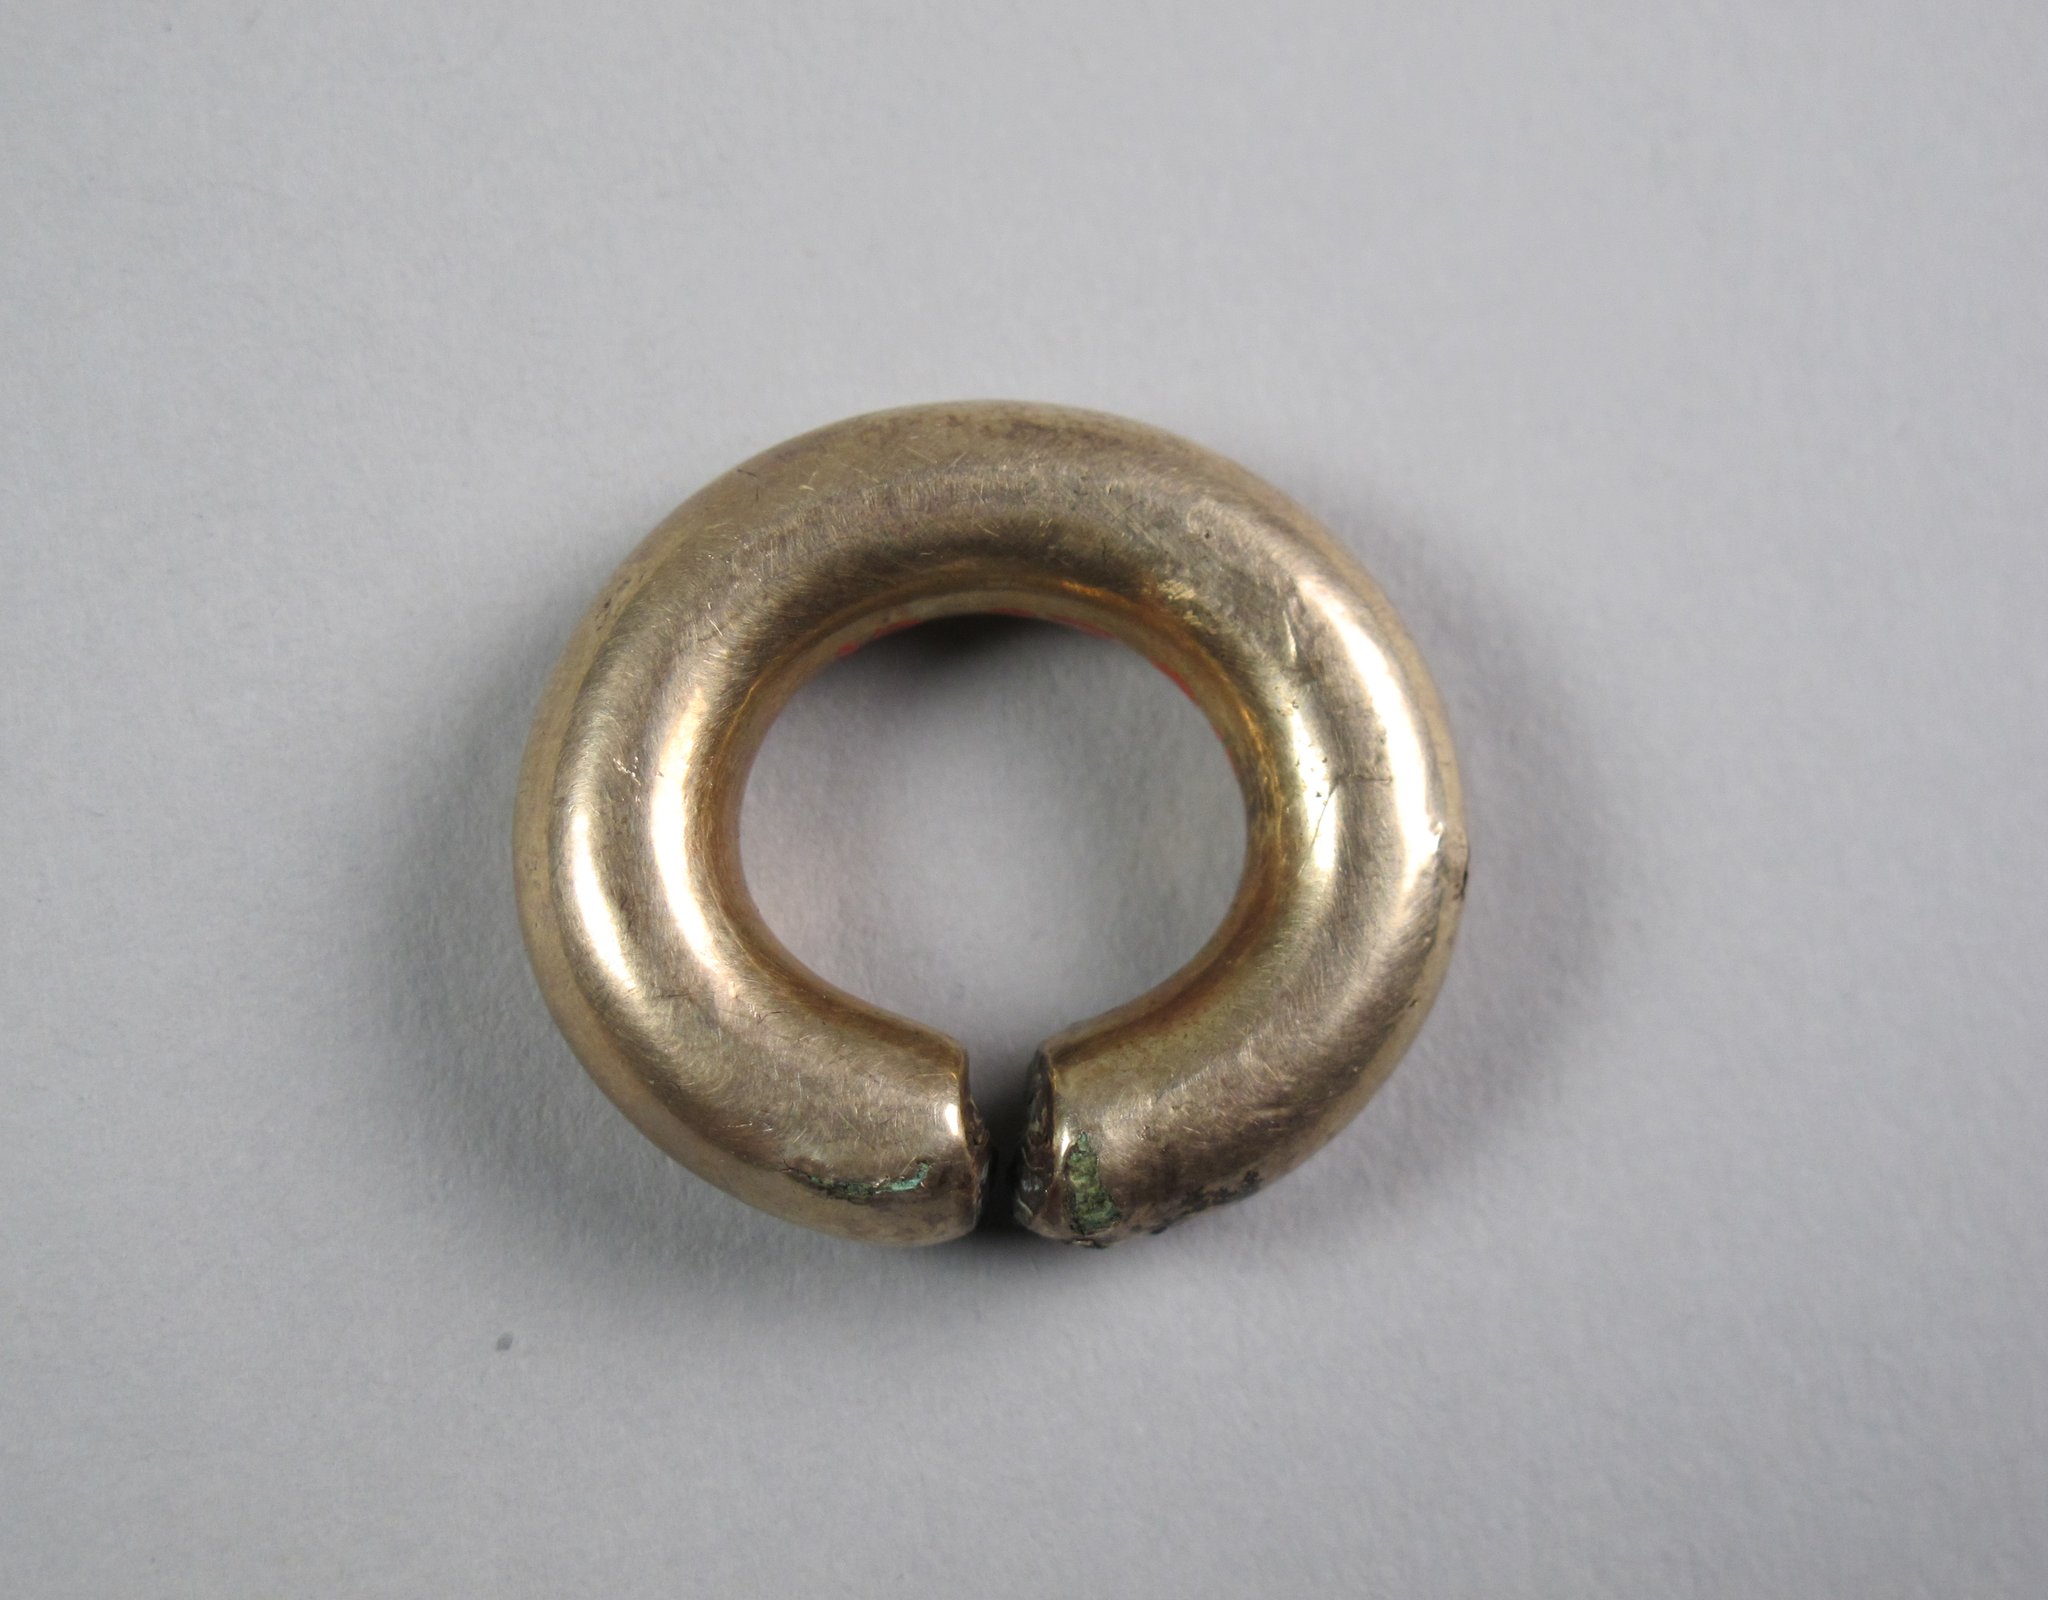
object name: earring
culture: japanese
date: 601-700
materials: metal